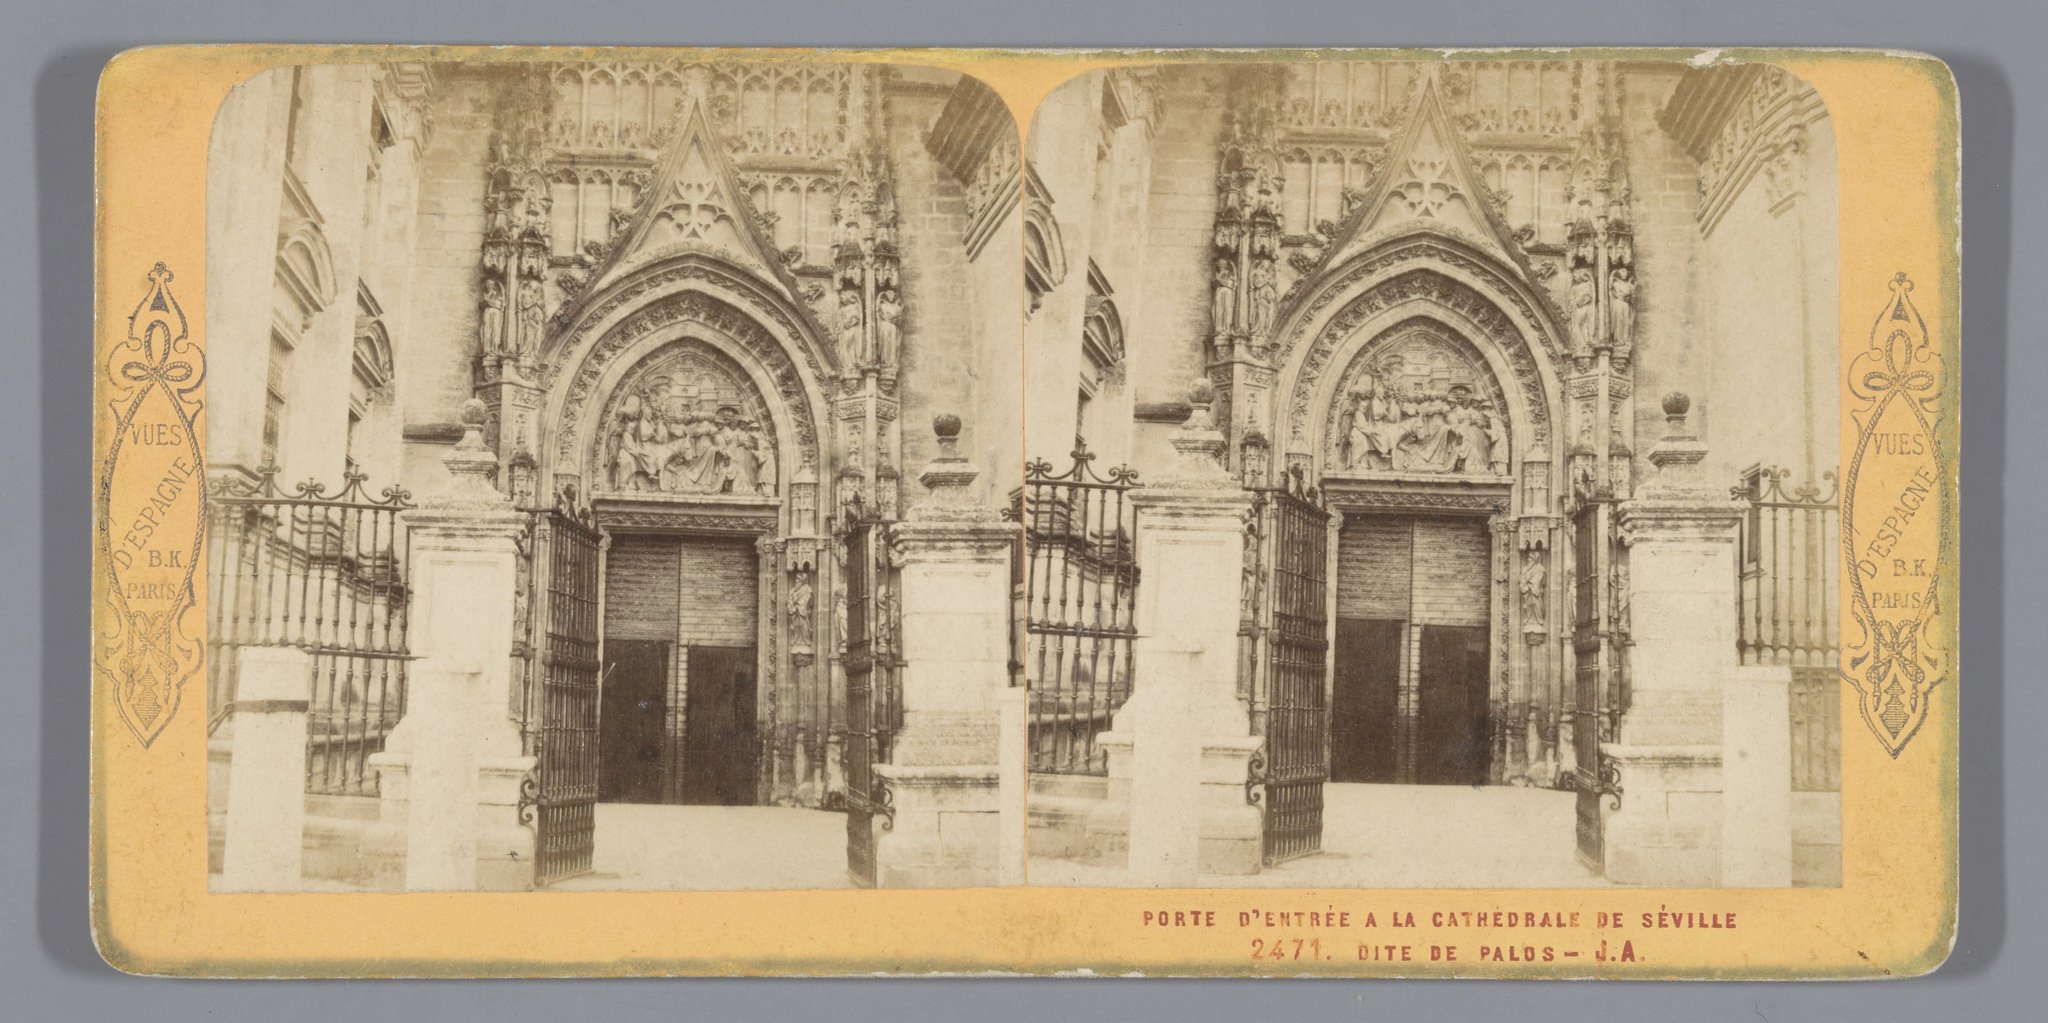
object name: stereograph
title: Porte d'entrée a la Cathédrale de Séville, dite de Palos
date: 1872-1876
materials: cardboard, photographic support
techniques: albumen print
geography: sevilla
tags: parts of church exterior and annexes: portal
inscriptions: inscription: ‘Vues d'Espagne’, number: ‘2471.’